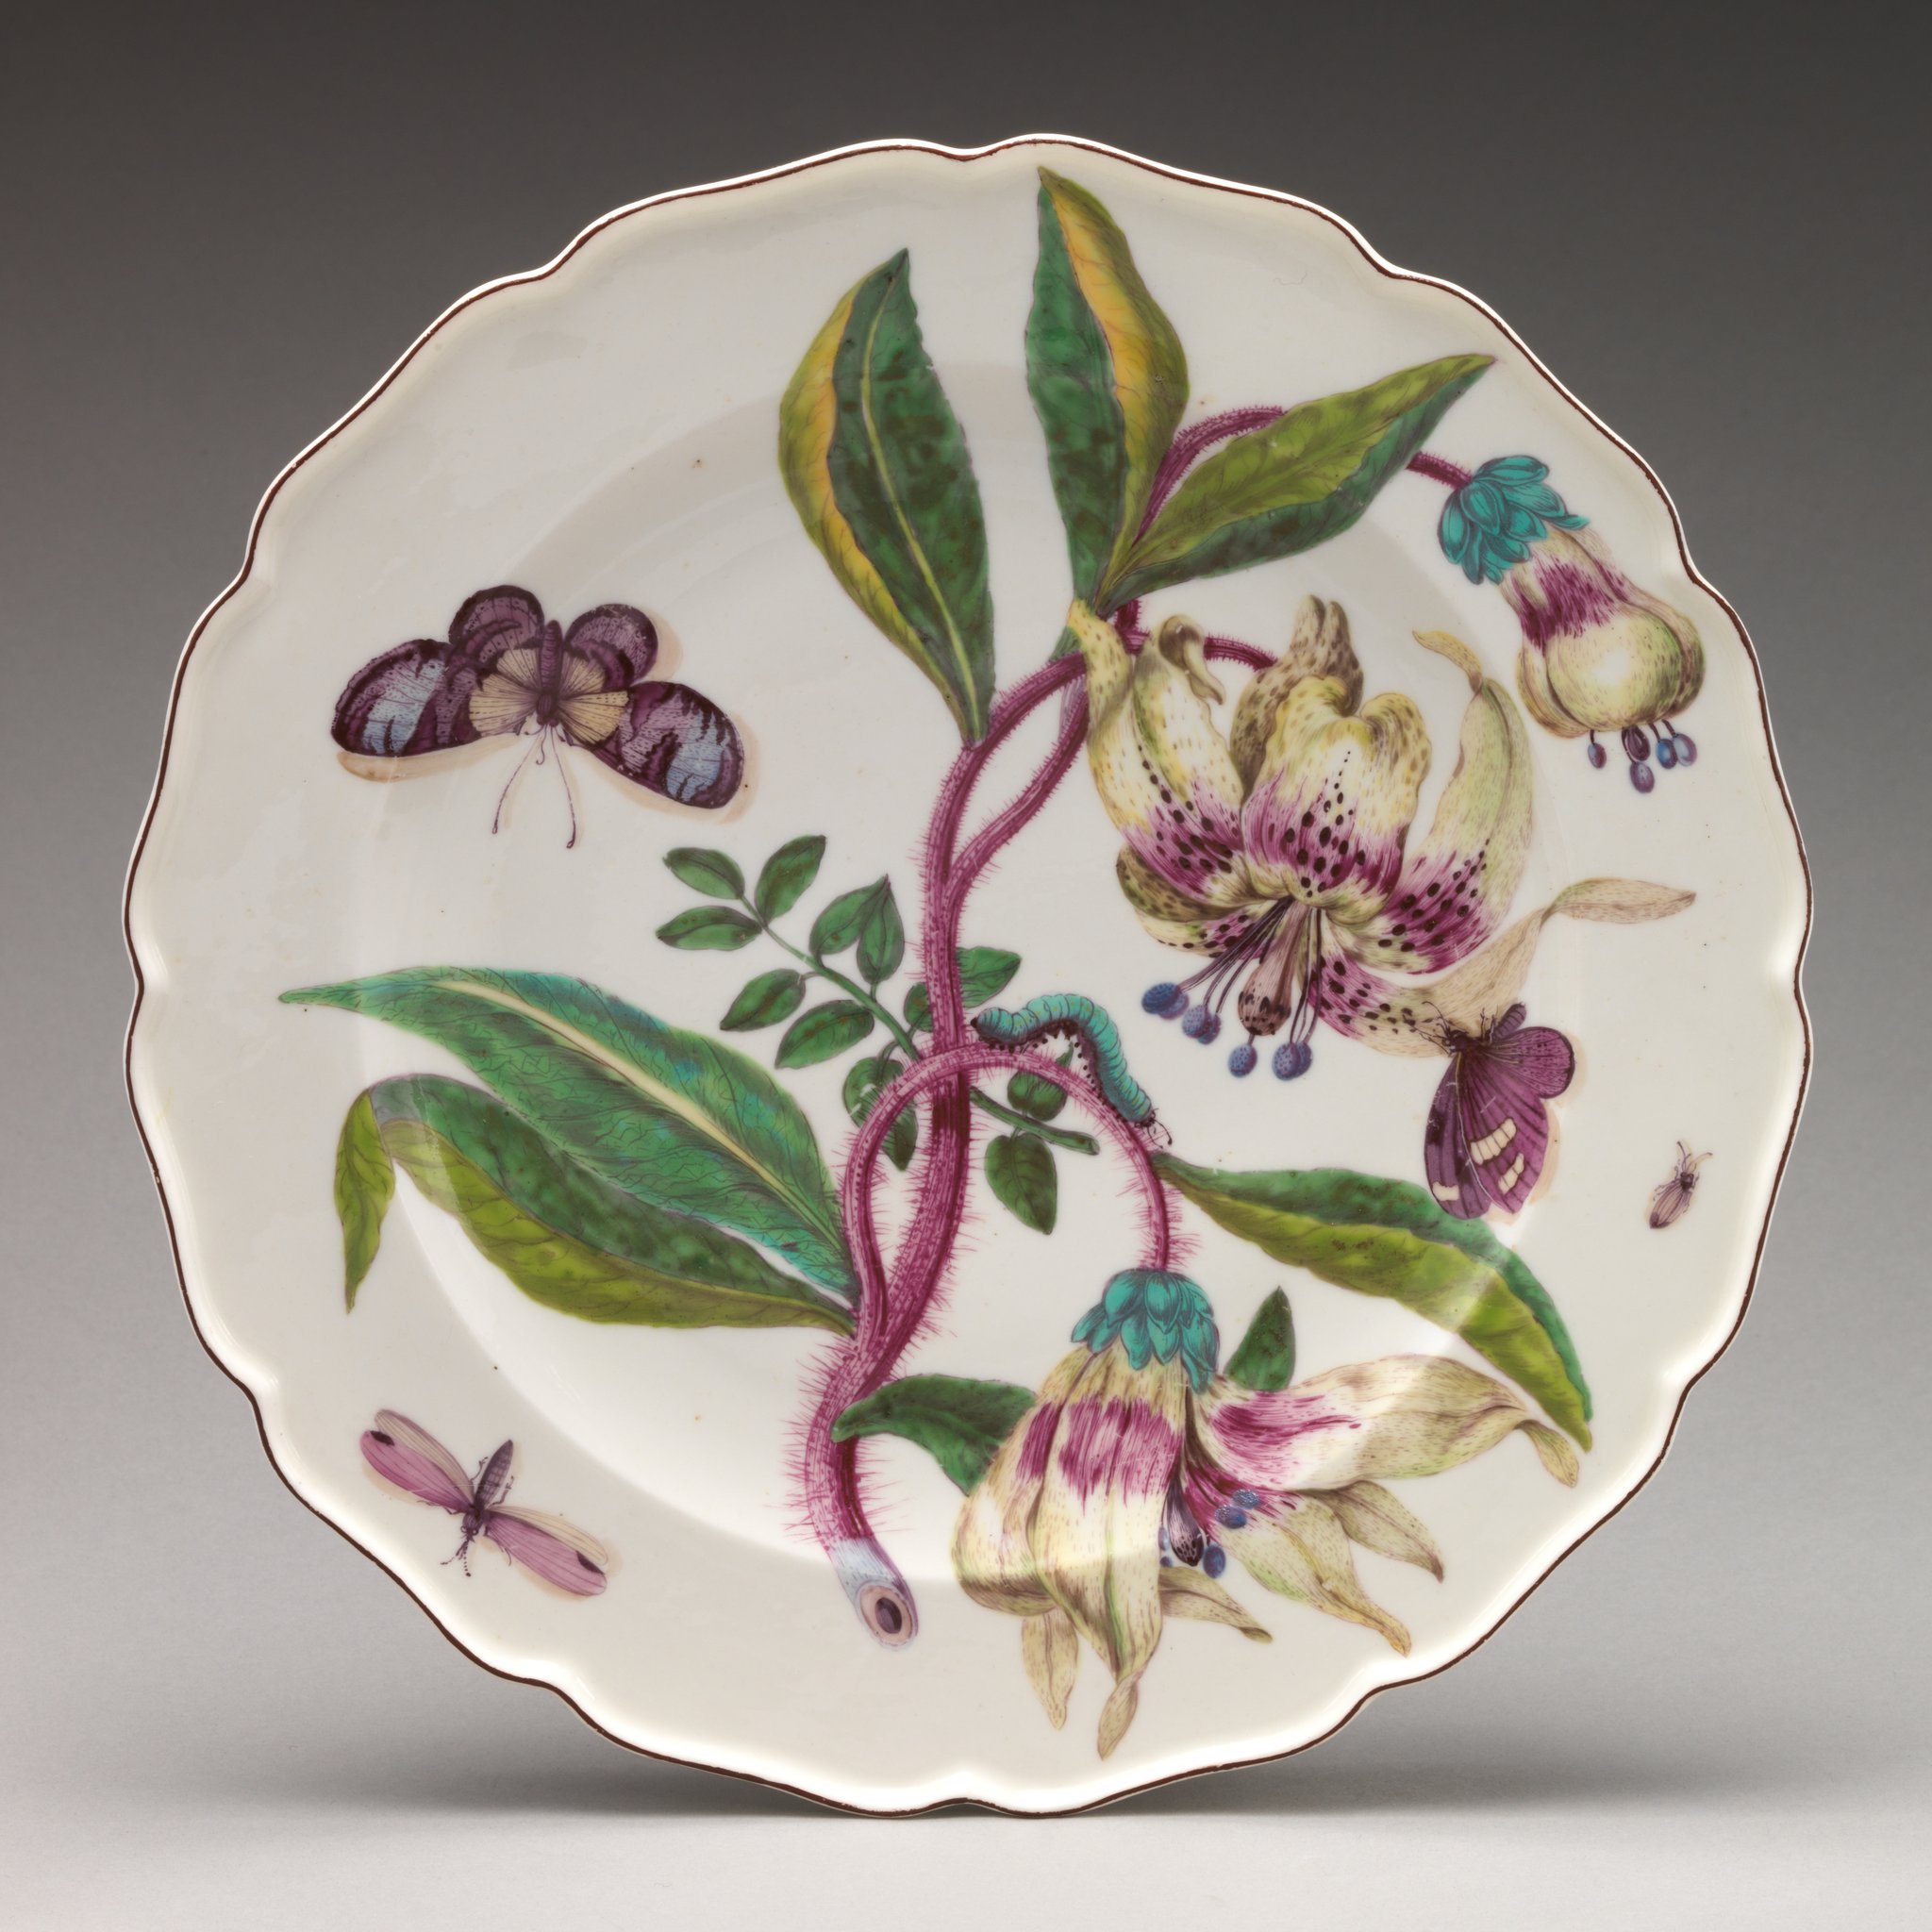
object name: dish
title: Botanical plate with spray of lilies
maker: chelsea porcelain manufactory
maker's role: factory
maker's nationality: british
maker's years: 1744-1784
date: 1755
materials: enamel, soft paste porcelain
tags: butterflies,lilies